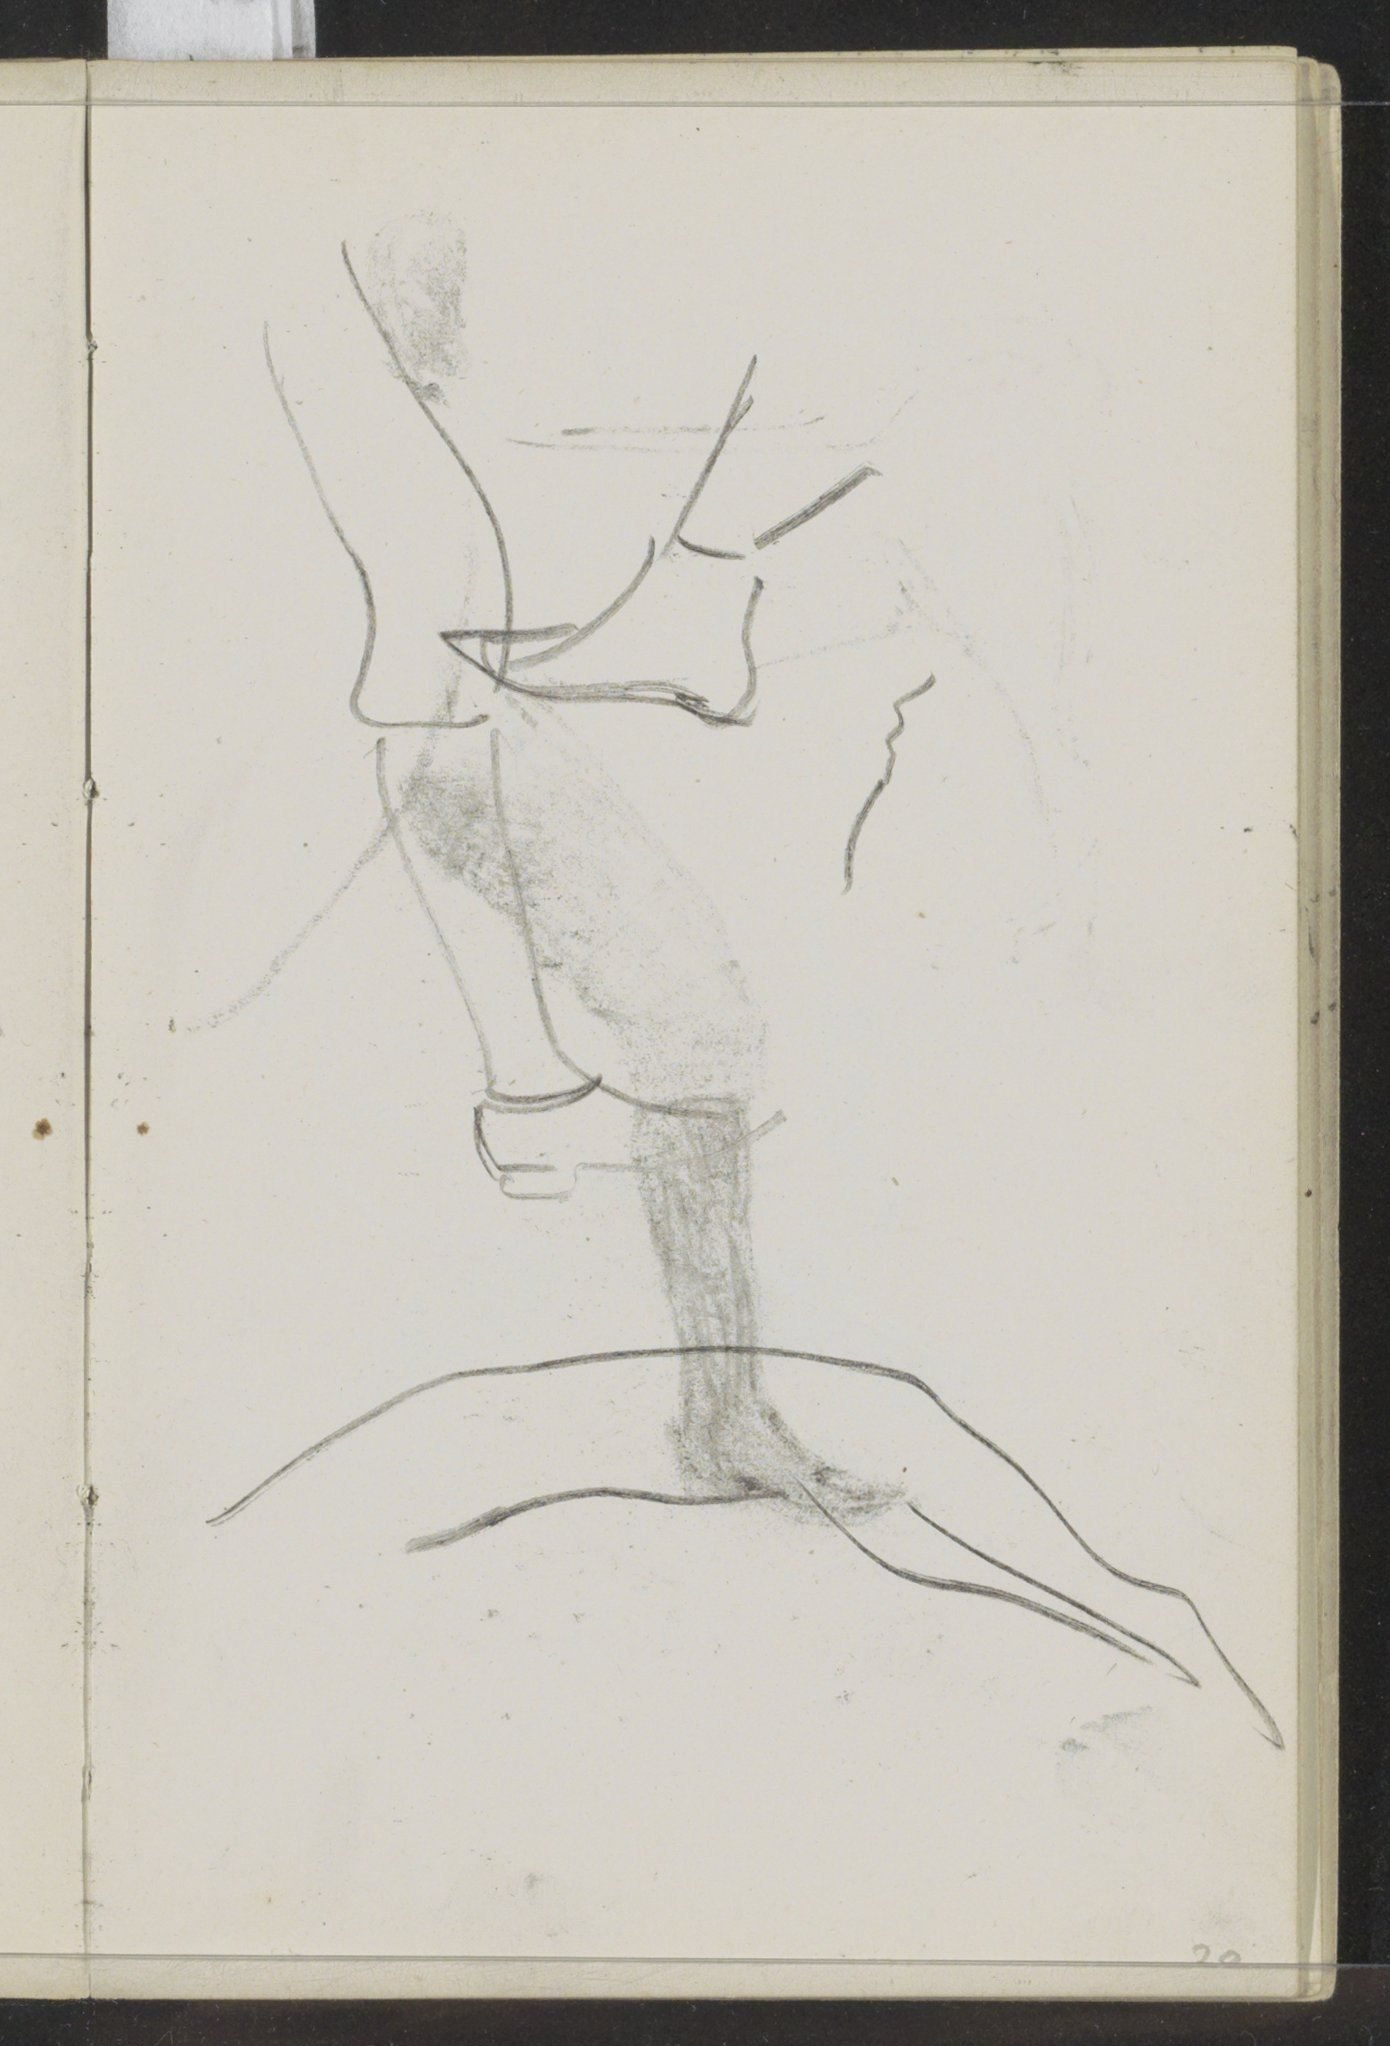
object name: sketchbook leaf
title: Benen en een voet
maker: carel adolph lion cachet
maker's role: draughtsman, print maker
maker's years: 1864-1945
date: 1874-1945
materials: chalk, paper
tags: foot, legs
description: Blad 20 recto uit een schetsboek met 41 bladen.